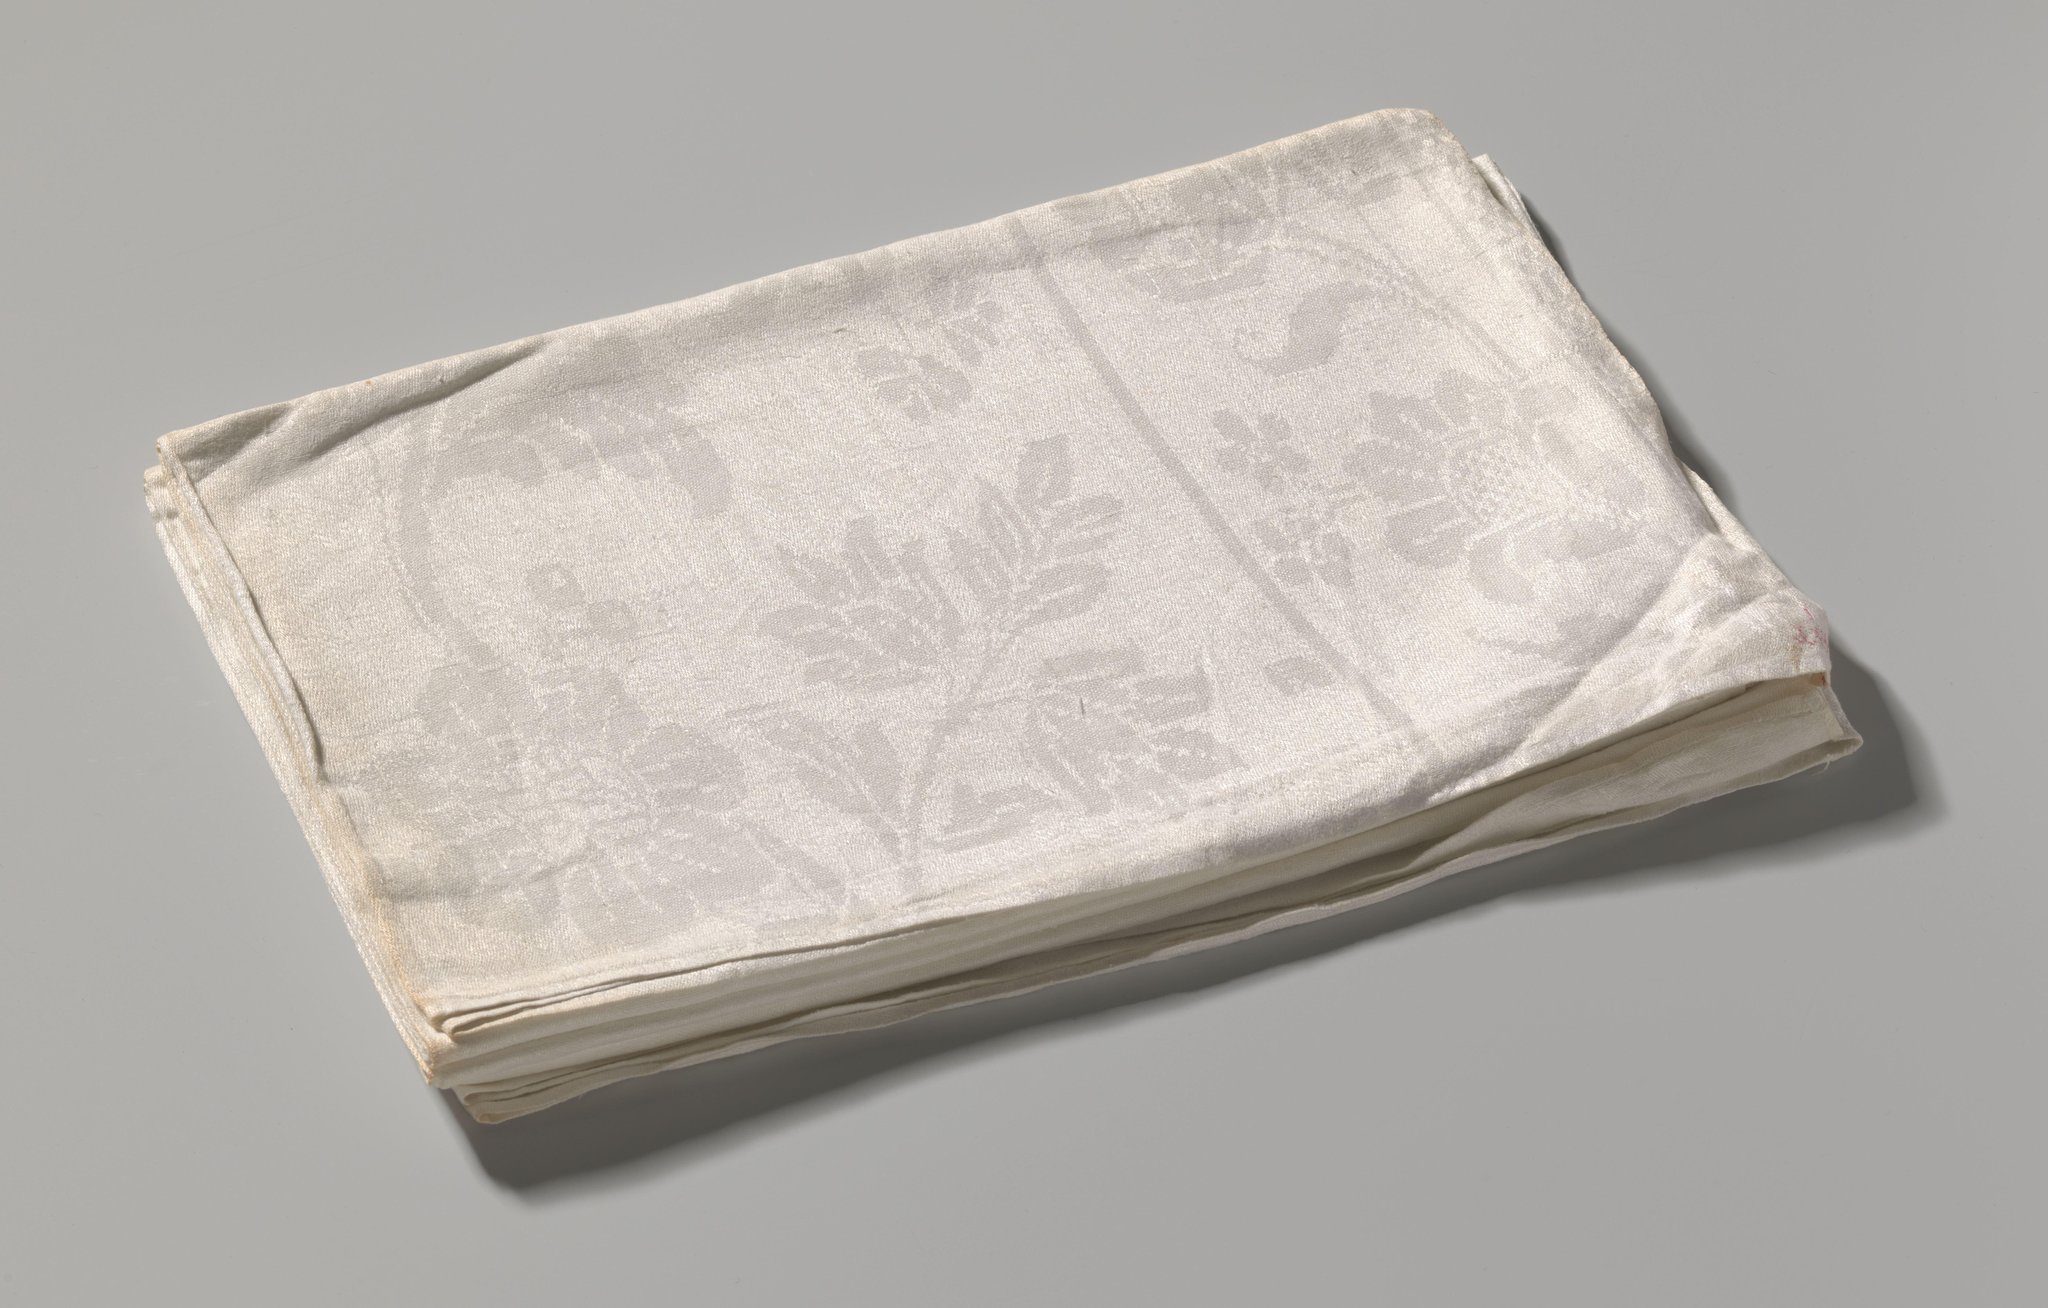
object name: towel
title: Tafellaken gemaakt van twee aan elkaar genaaide dwalen met groot slingermotief van bloemen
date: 1735-1740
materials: linen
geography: germany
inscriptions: mark: ‘VHT I’, mark: ‘y x’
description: Twee tot tafellaken aaneengezette handdwalen van wit linnendamast met groot slingermotief van bloemen. Gemerkt met rode kruissteek VHT 1.